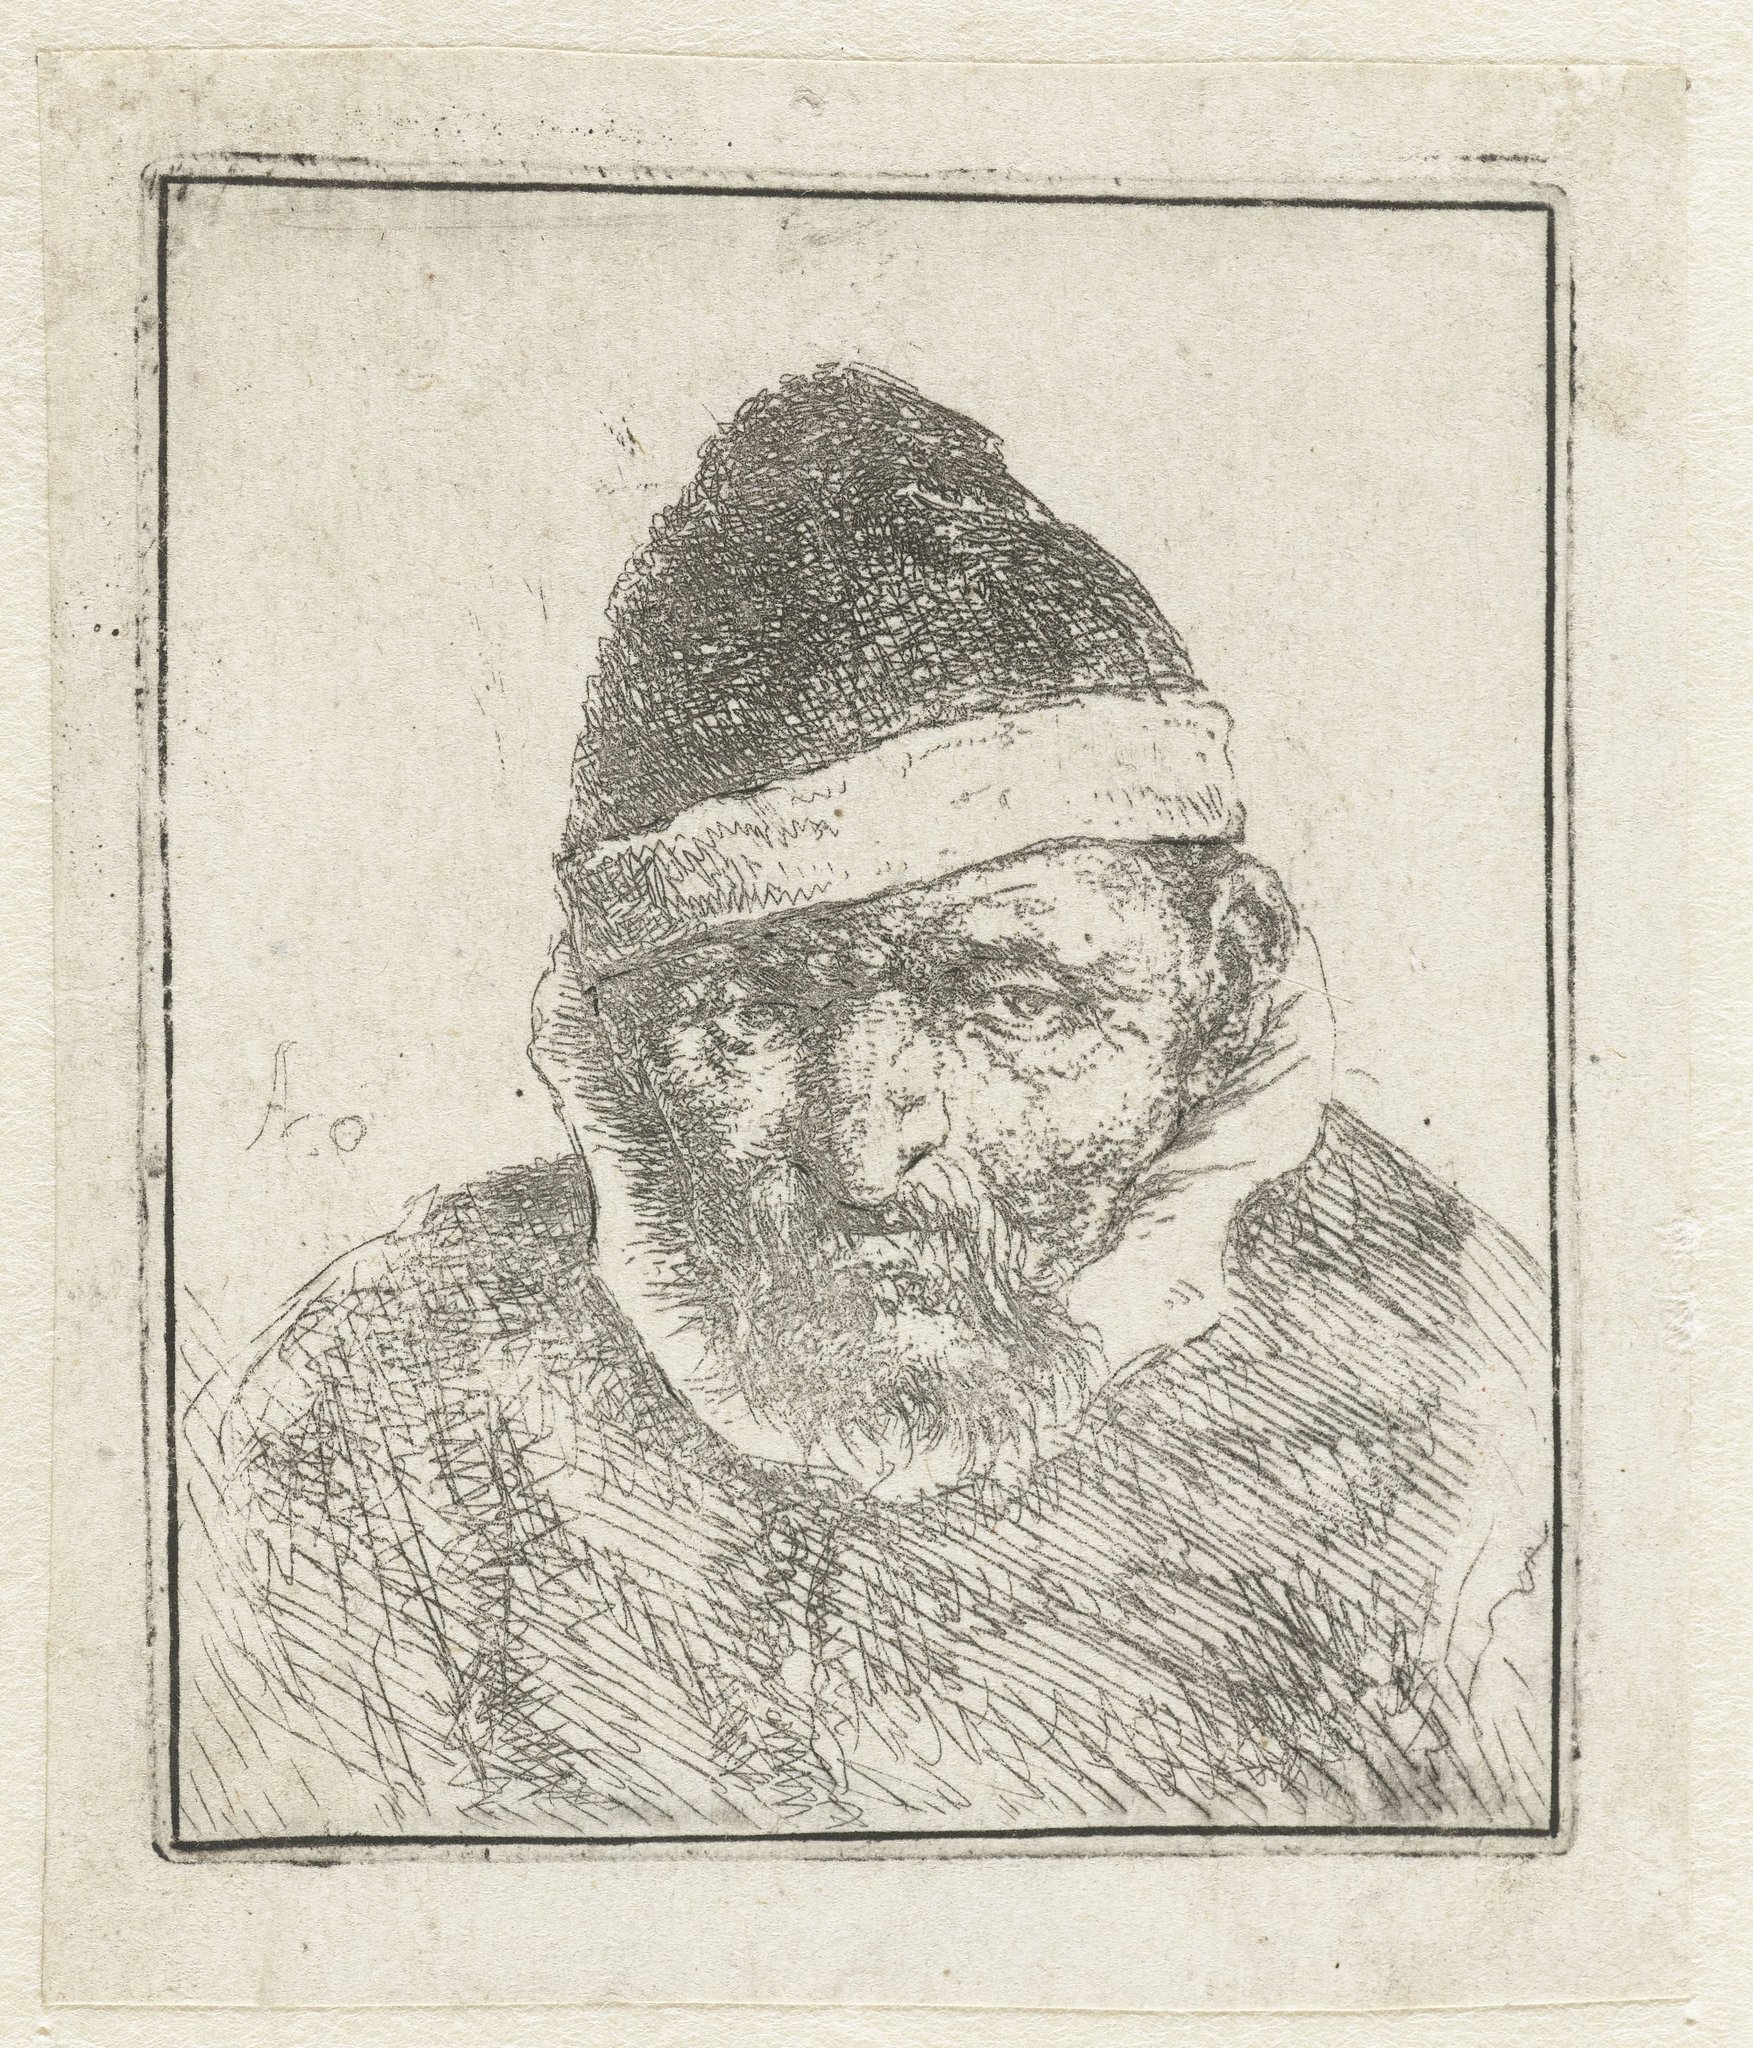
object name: print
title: Buste van een oude boer met een puntmuts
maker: adriaen van ostade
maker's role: draughtsman, painter, print maker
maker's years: 1610-1685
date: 1648-1650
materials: paper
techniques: etching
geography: haarlem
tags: head-gear: cap (+ men's clothes), old man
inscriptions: collector's mark: Lugt 240